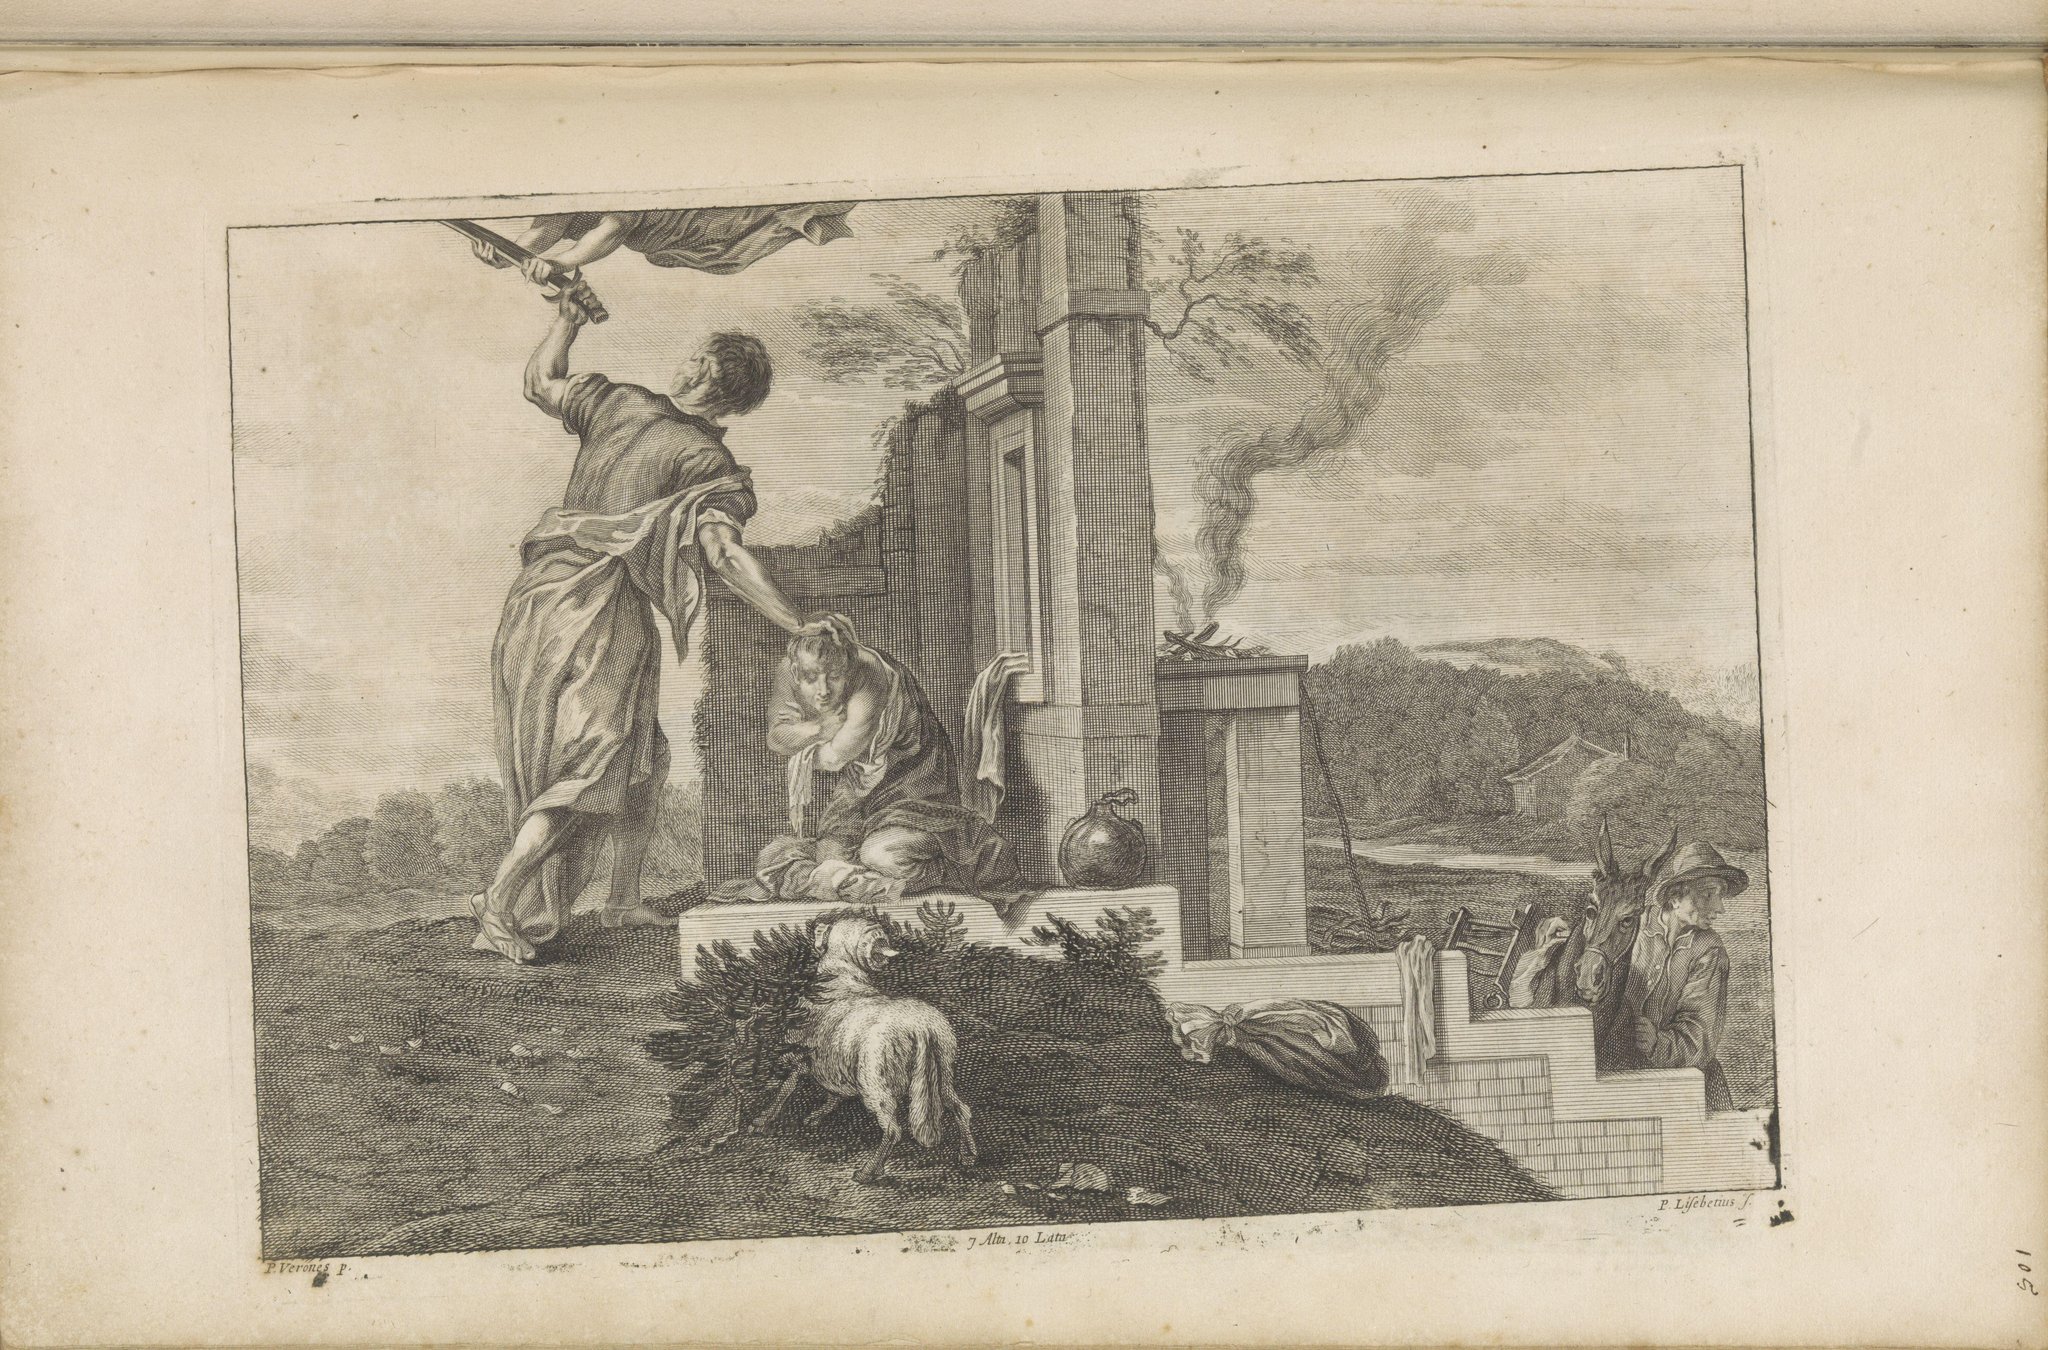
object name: print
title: Offer van Isaak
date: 1660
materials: paper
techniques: engraving, etching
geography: antwerp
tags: when abraham has his hand raised to kill isaac, an angel restrains abraham's hand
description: De prent is vervaardigd naar een schilderij van Veronese en zijn atelier dat zich in de collectie van het Kunsthistorisches Museum te Wenen bevindt (inventarisnummer GG_3825). David Teniers heeft waarschijnlijk van alle schilderijen uit de collectie van Leopold Willem van Oostenrijk een olieverfstudie op doek of paneel vervaardigd (zgn. pasticcio), die als voorbeeld voor de prentmakers diende. Het is niet altijd duidelijk of de pasticci door hem zijn gemaakt of door zijn atelier. Niet alle pasticci zijn overgeleverd.